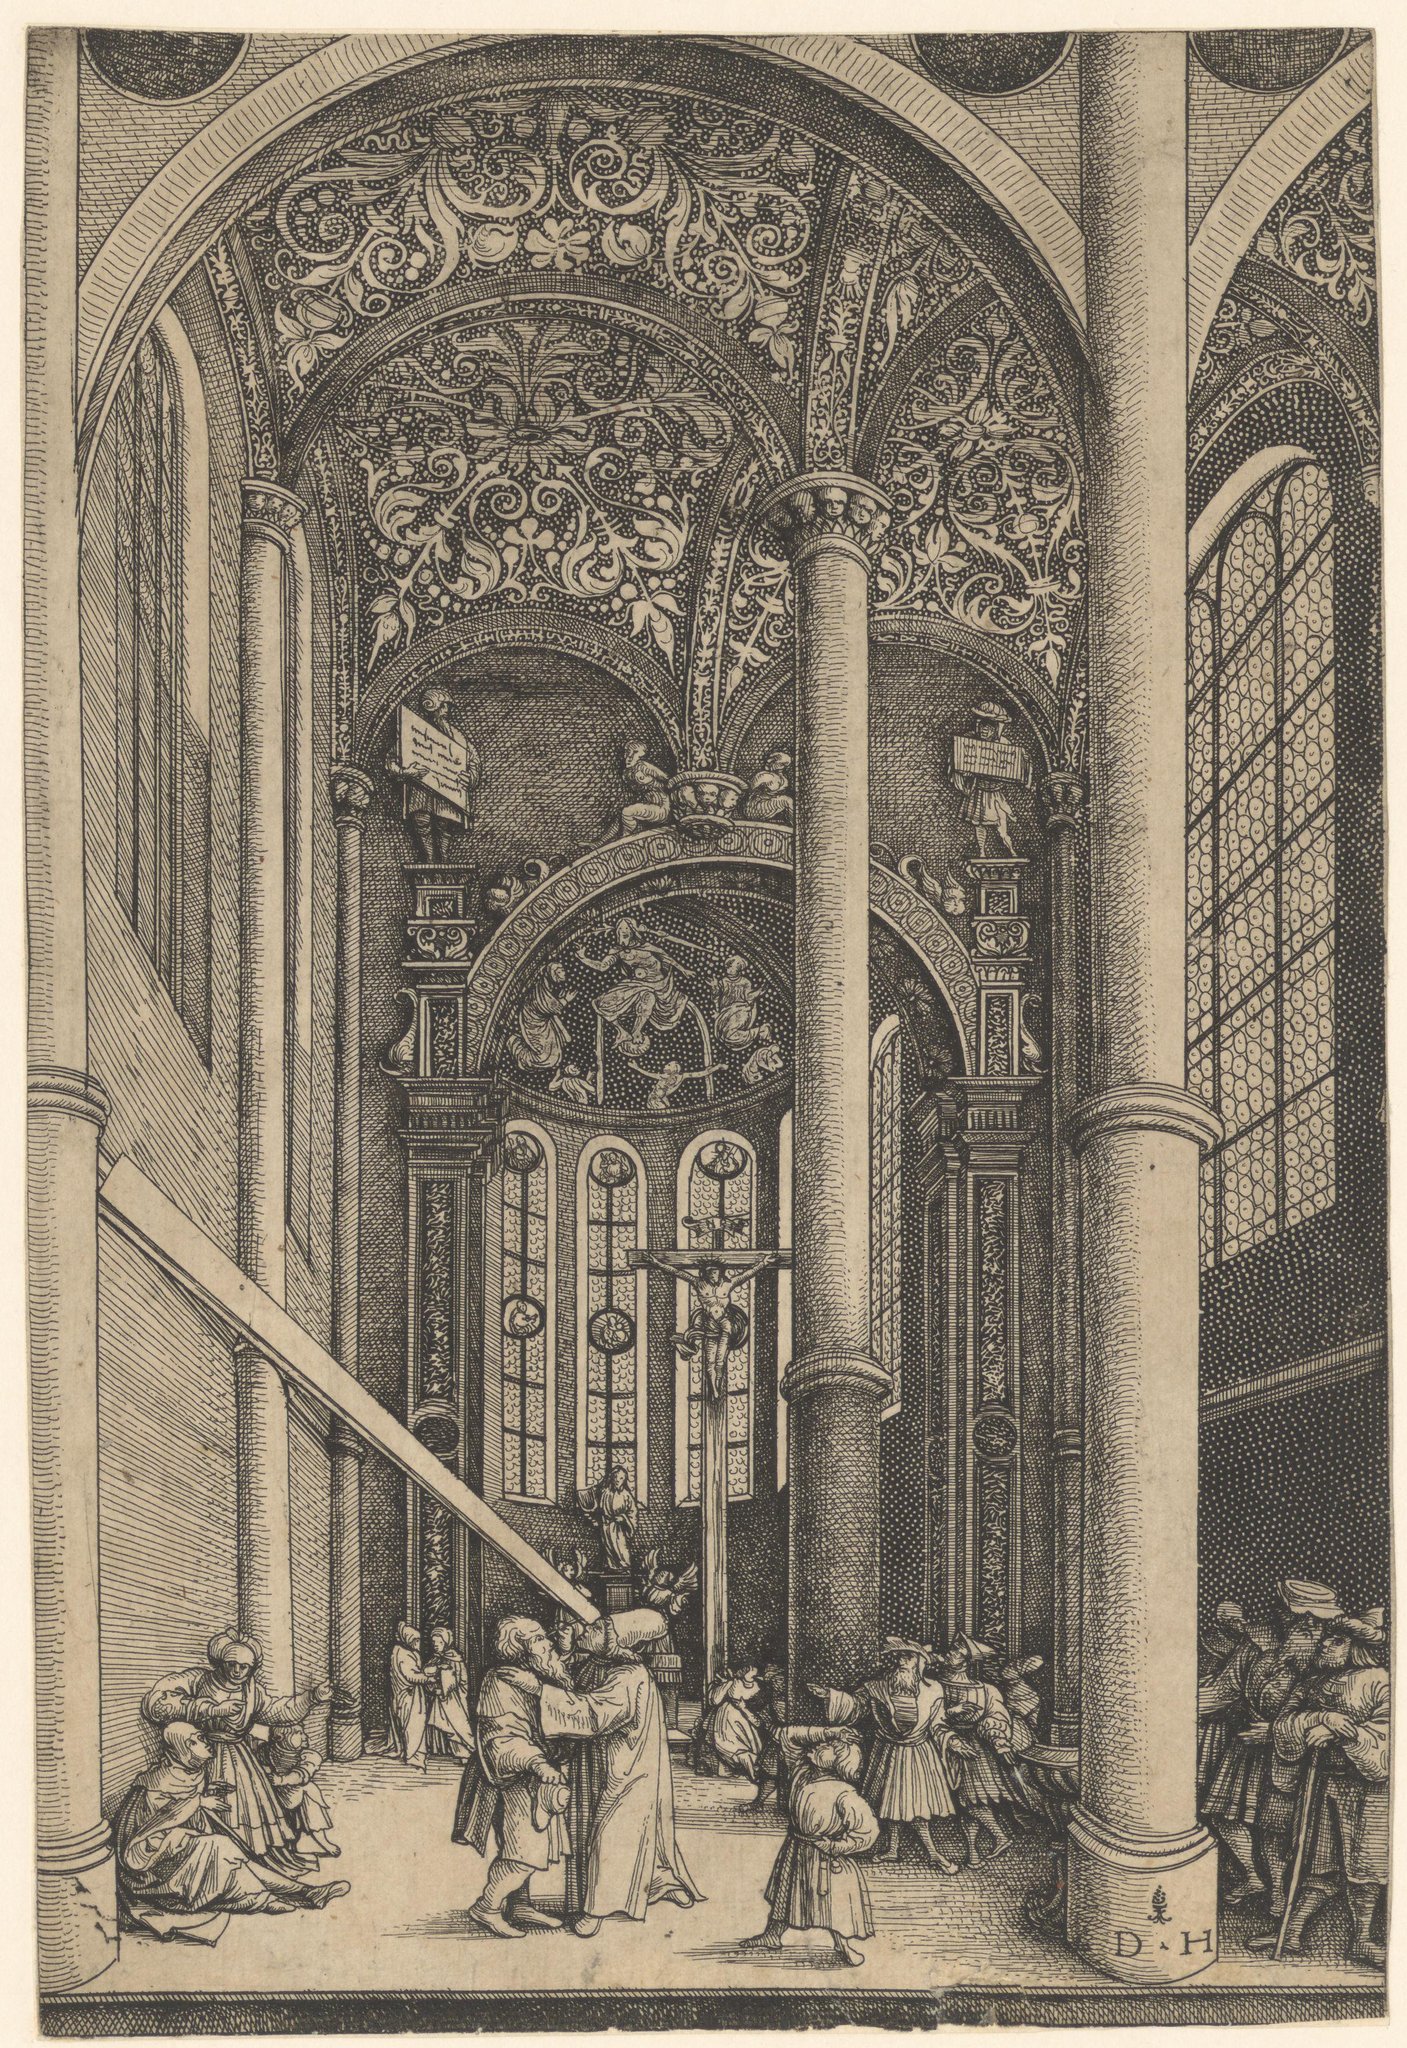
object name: print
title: Parabel van de splinter en de balk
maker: daniel hopfer (i)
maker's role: print maker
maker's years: 1470-1536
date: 1518-1520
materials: paper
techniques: etching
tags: the mote and the beam in the eye ~ doctrine of christ on love, etc. (matthew 7:4; luke 6:42), augsburg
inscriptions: collector's mark: Lugt 2228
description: Voorstelling van de metafoor uit Mat. 7:3-5 waarin het ongelijk behandelen van gelijksoortige zaken wordt aangekaart. Kerkinterieur van het Dominaanse Sint Katharina Convent in Augsburg als achtergrond.